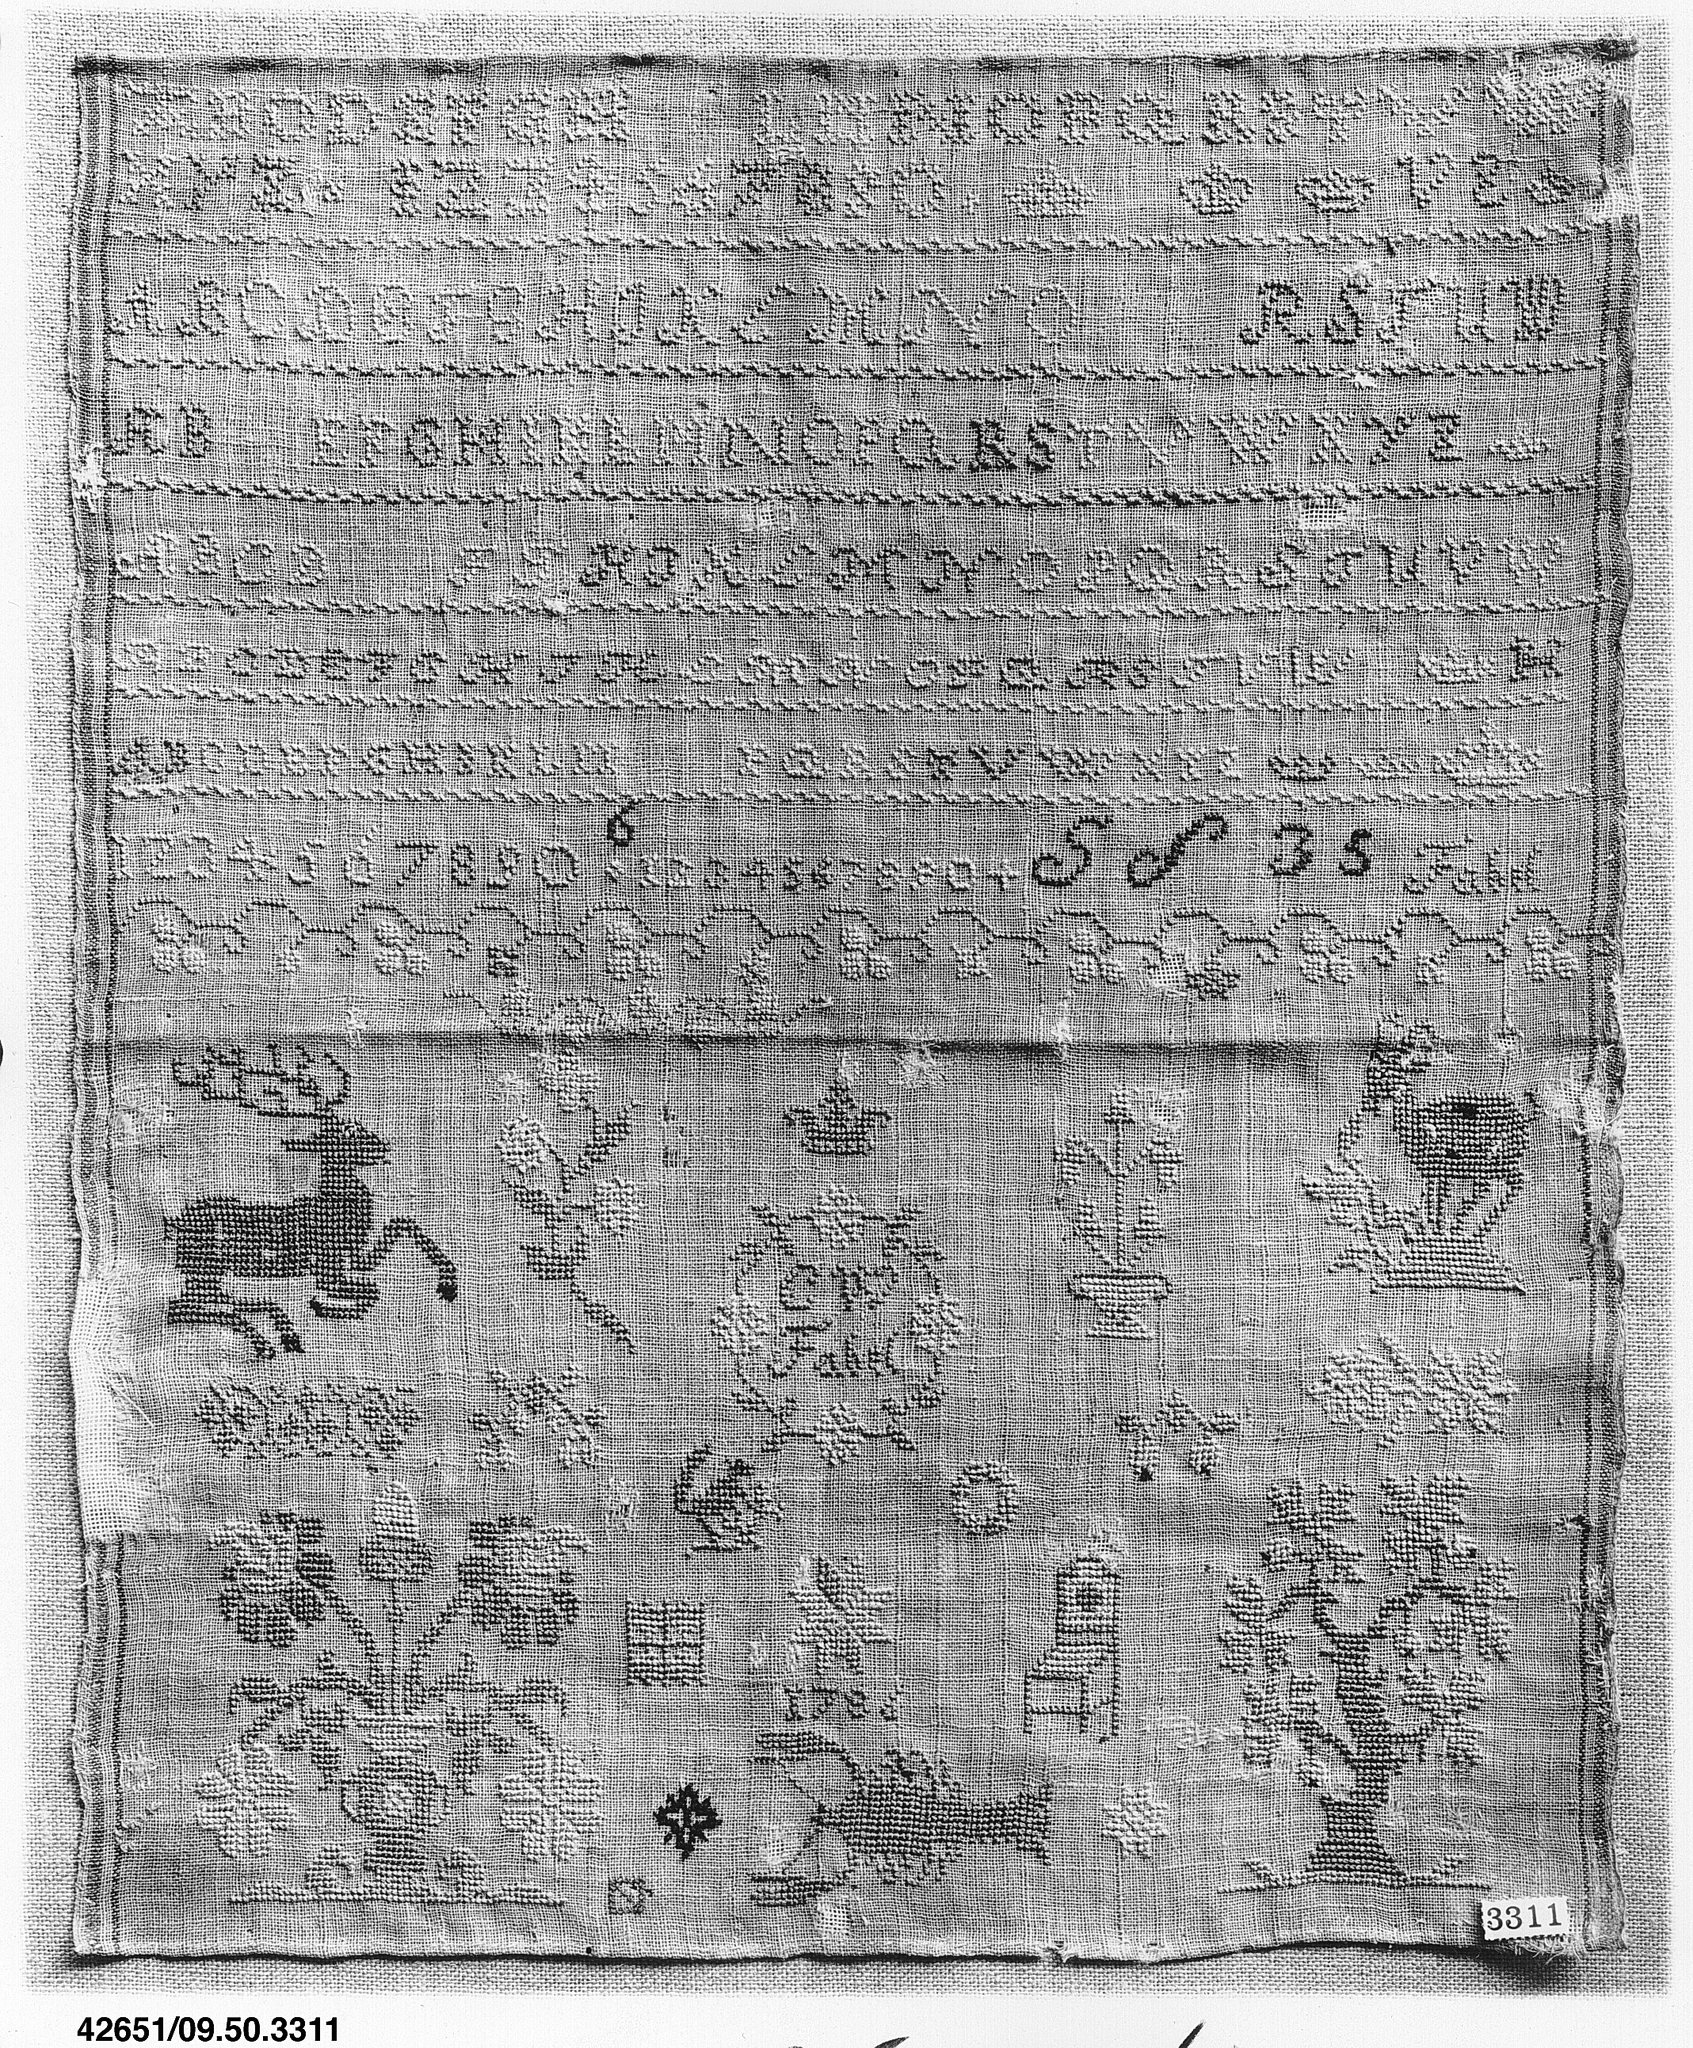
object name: sampler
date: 1786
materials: canvas, linen, silk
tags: animals,flowers